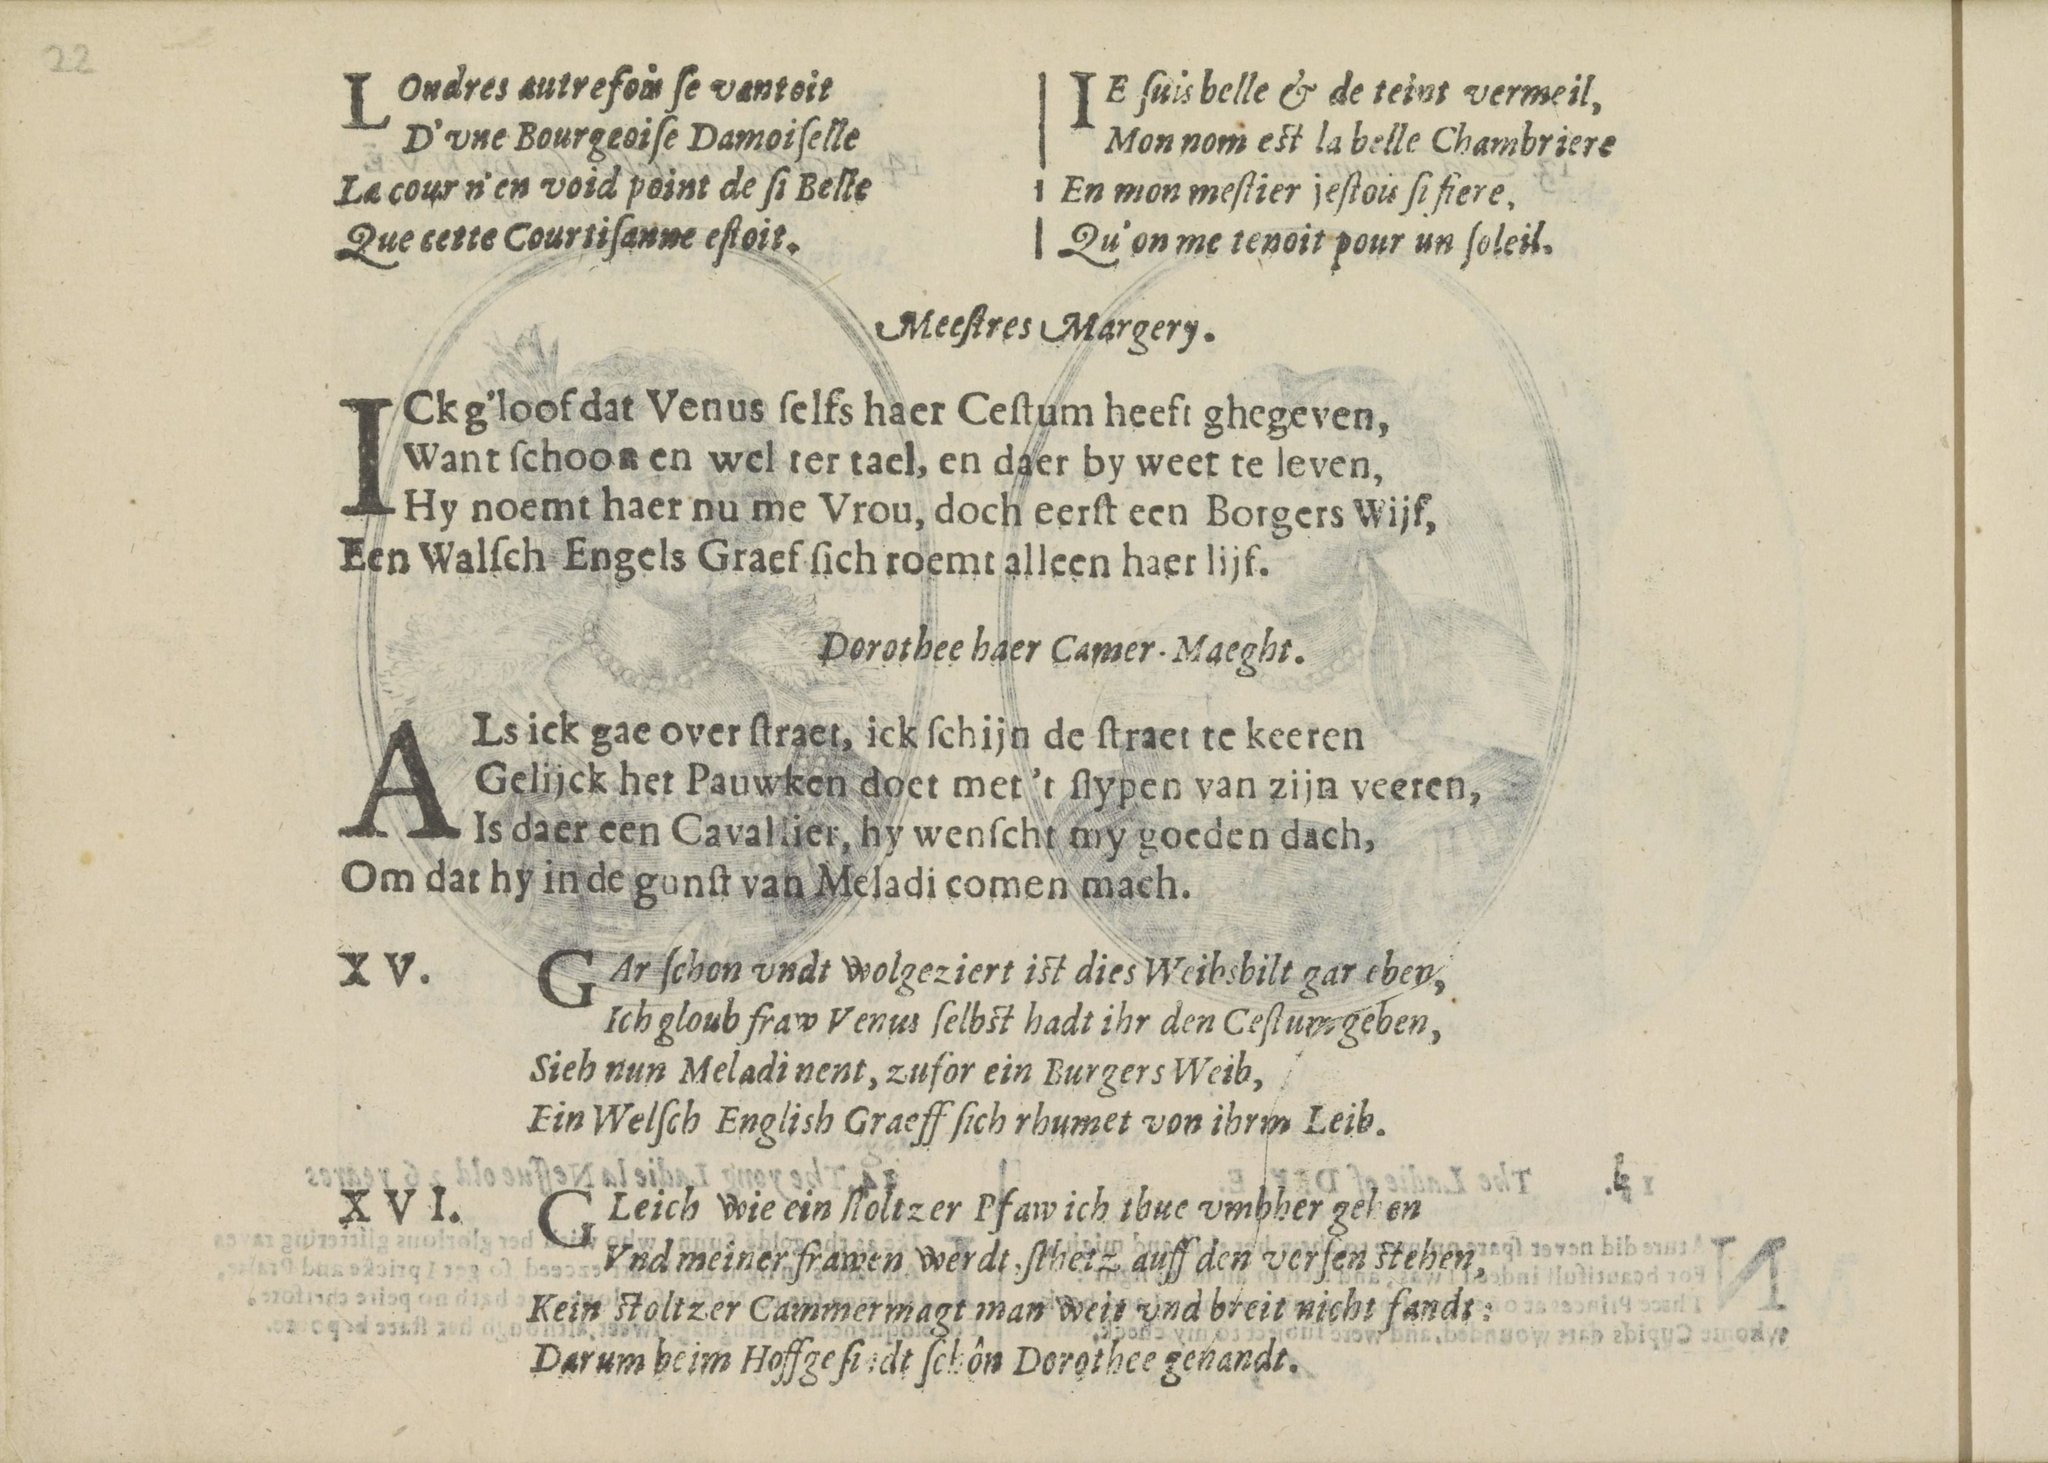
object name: album leaf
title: Mr Margery of Richmond / Dority her Chambermaide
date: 1635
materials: paper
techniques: engraving, letterpress printing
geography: utrecht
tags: herding, herdsman, herdswoman, shepherd, shepherdess, cowherd, etc.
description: Twee voorstellingen op een albumblad. Links de courtisane Magery van Richmond, de haren kammend. Rechts haar dienstmeid Dority (Dorothee). Daaronder twee kwatrijnen in het Engels. Het blad maakt deel uit van een album.